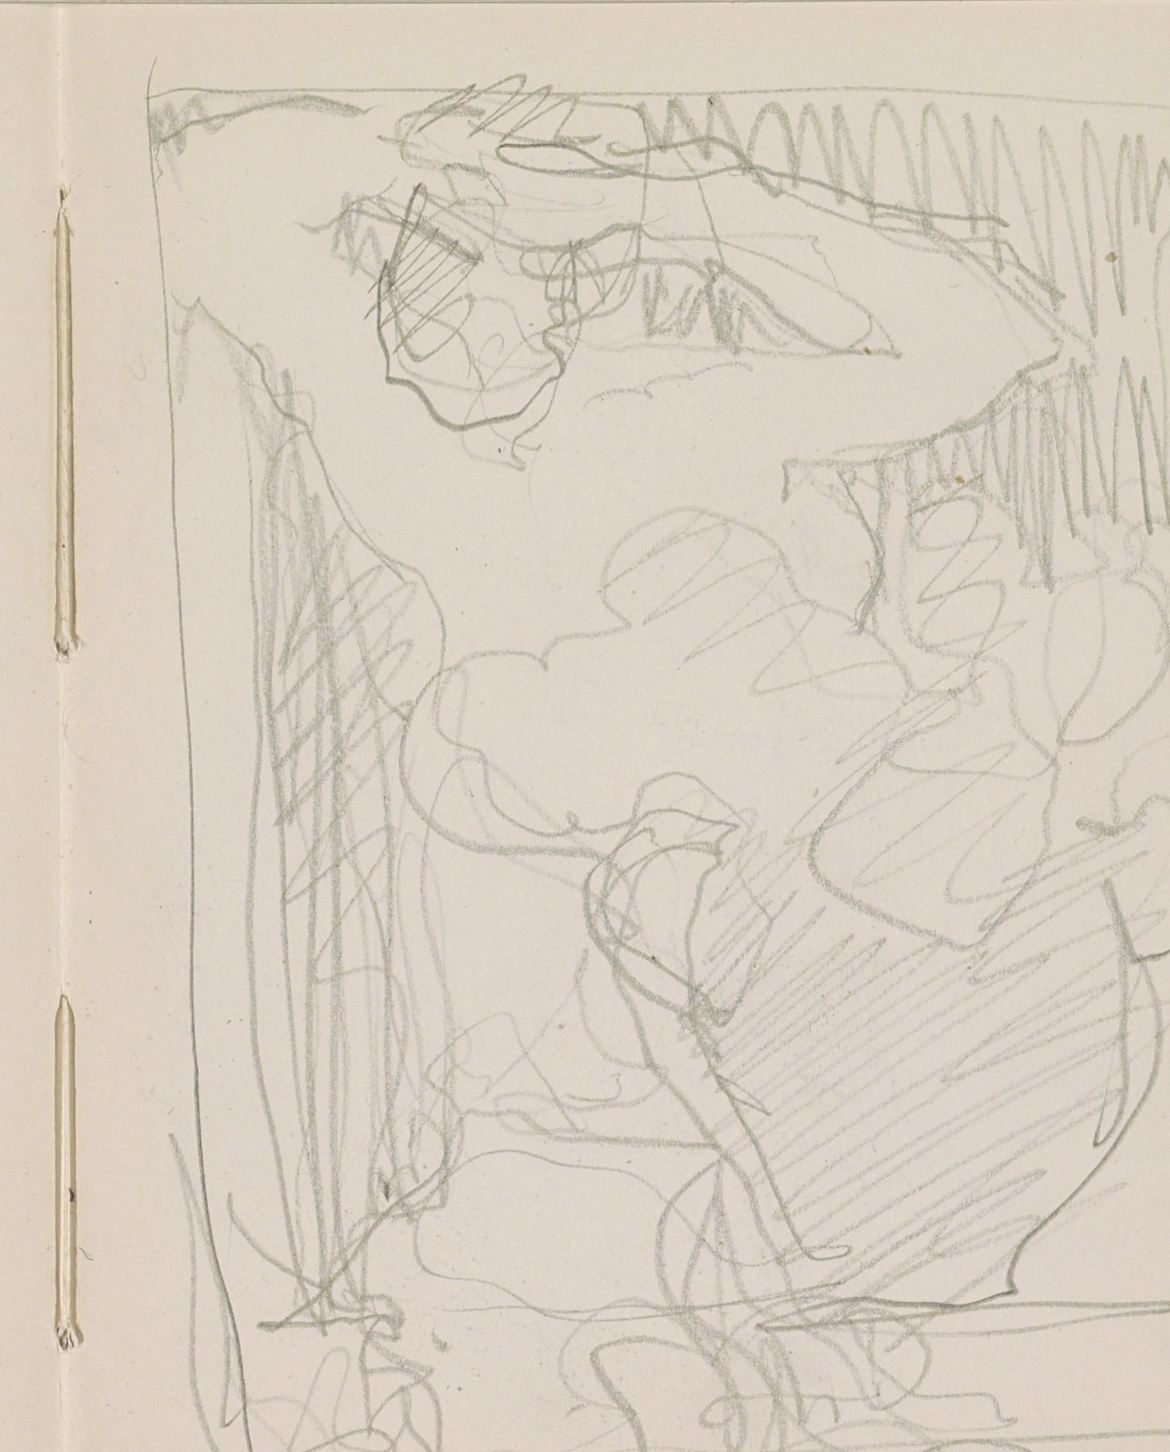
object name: sketchbook leaf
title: Figuurstudie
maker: reijer stolk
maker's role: draughtsman, print maker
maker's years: 1896-1945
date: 1916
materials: paper, pencil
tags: anatomy (non-medical)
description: Blad 54 recto uit een schetsboek met 72 bladen.